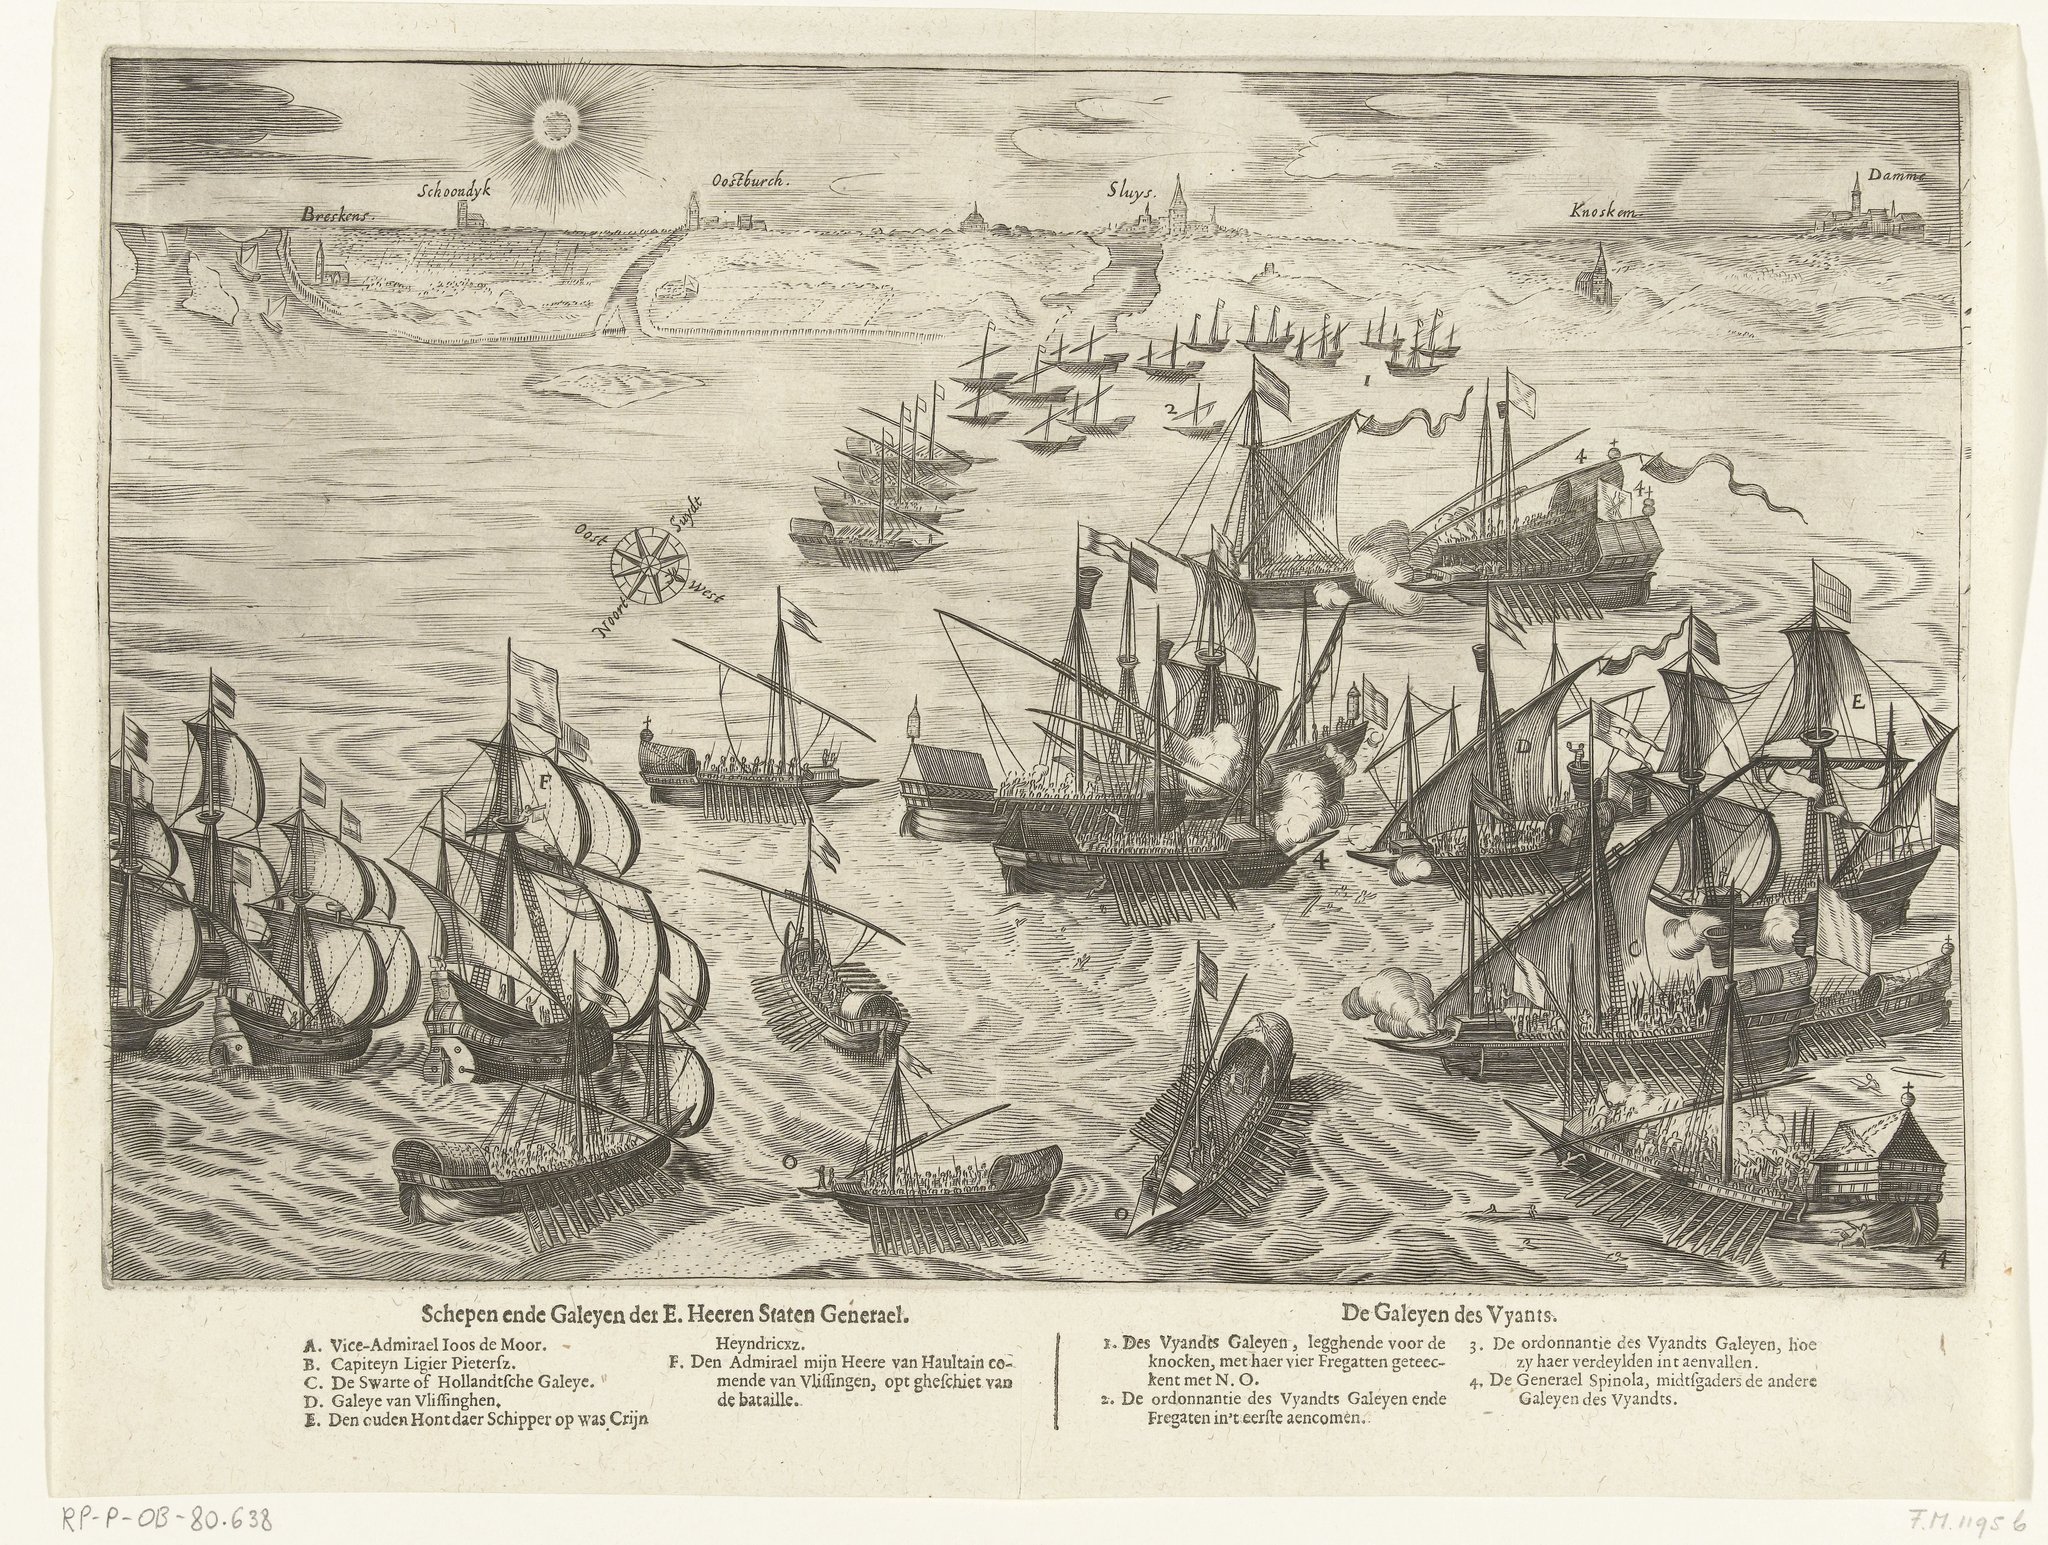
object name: print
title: Zeeslag waarbij de acht galeien van Spinola worden verslagen door de vloot van Joos de Moor, 1603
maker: bartholomeus willemsz. dolendo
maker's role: print maker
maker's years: 1560-1626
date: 1603-1610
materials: paper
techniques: engraving, letterpress printing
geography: northern netherlands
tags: flushing, battle (+ naval force), warfare; military affairs (+ oared ships, e.g.: galley), trireme, galley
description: Gebruikt als illustratie in: J.J. Orlers, Den Nassauschen Lauren-Crans: Beschrijvinghe ende af-beeldinge van alle de victorien ... die Godt Almachtich de ... Staten der Vereenichde Nederlanden verleent heeft, deur het wijs ende clouck beleyt des Hooch-ghebooren Fursts Maurits van Nassau, J.J. Orlers en H. van Haestens, Leiden 1610, fol. 198/199. In het klappertje is bij dit nummer geannoteerd: "vroegere druk in: Niederl. Kriegsjournael 1603/05 met Duitse tekst, eigendom UB Asd (nr. 1515A19)." Deze publicatie echter niet getraceerd.